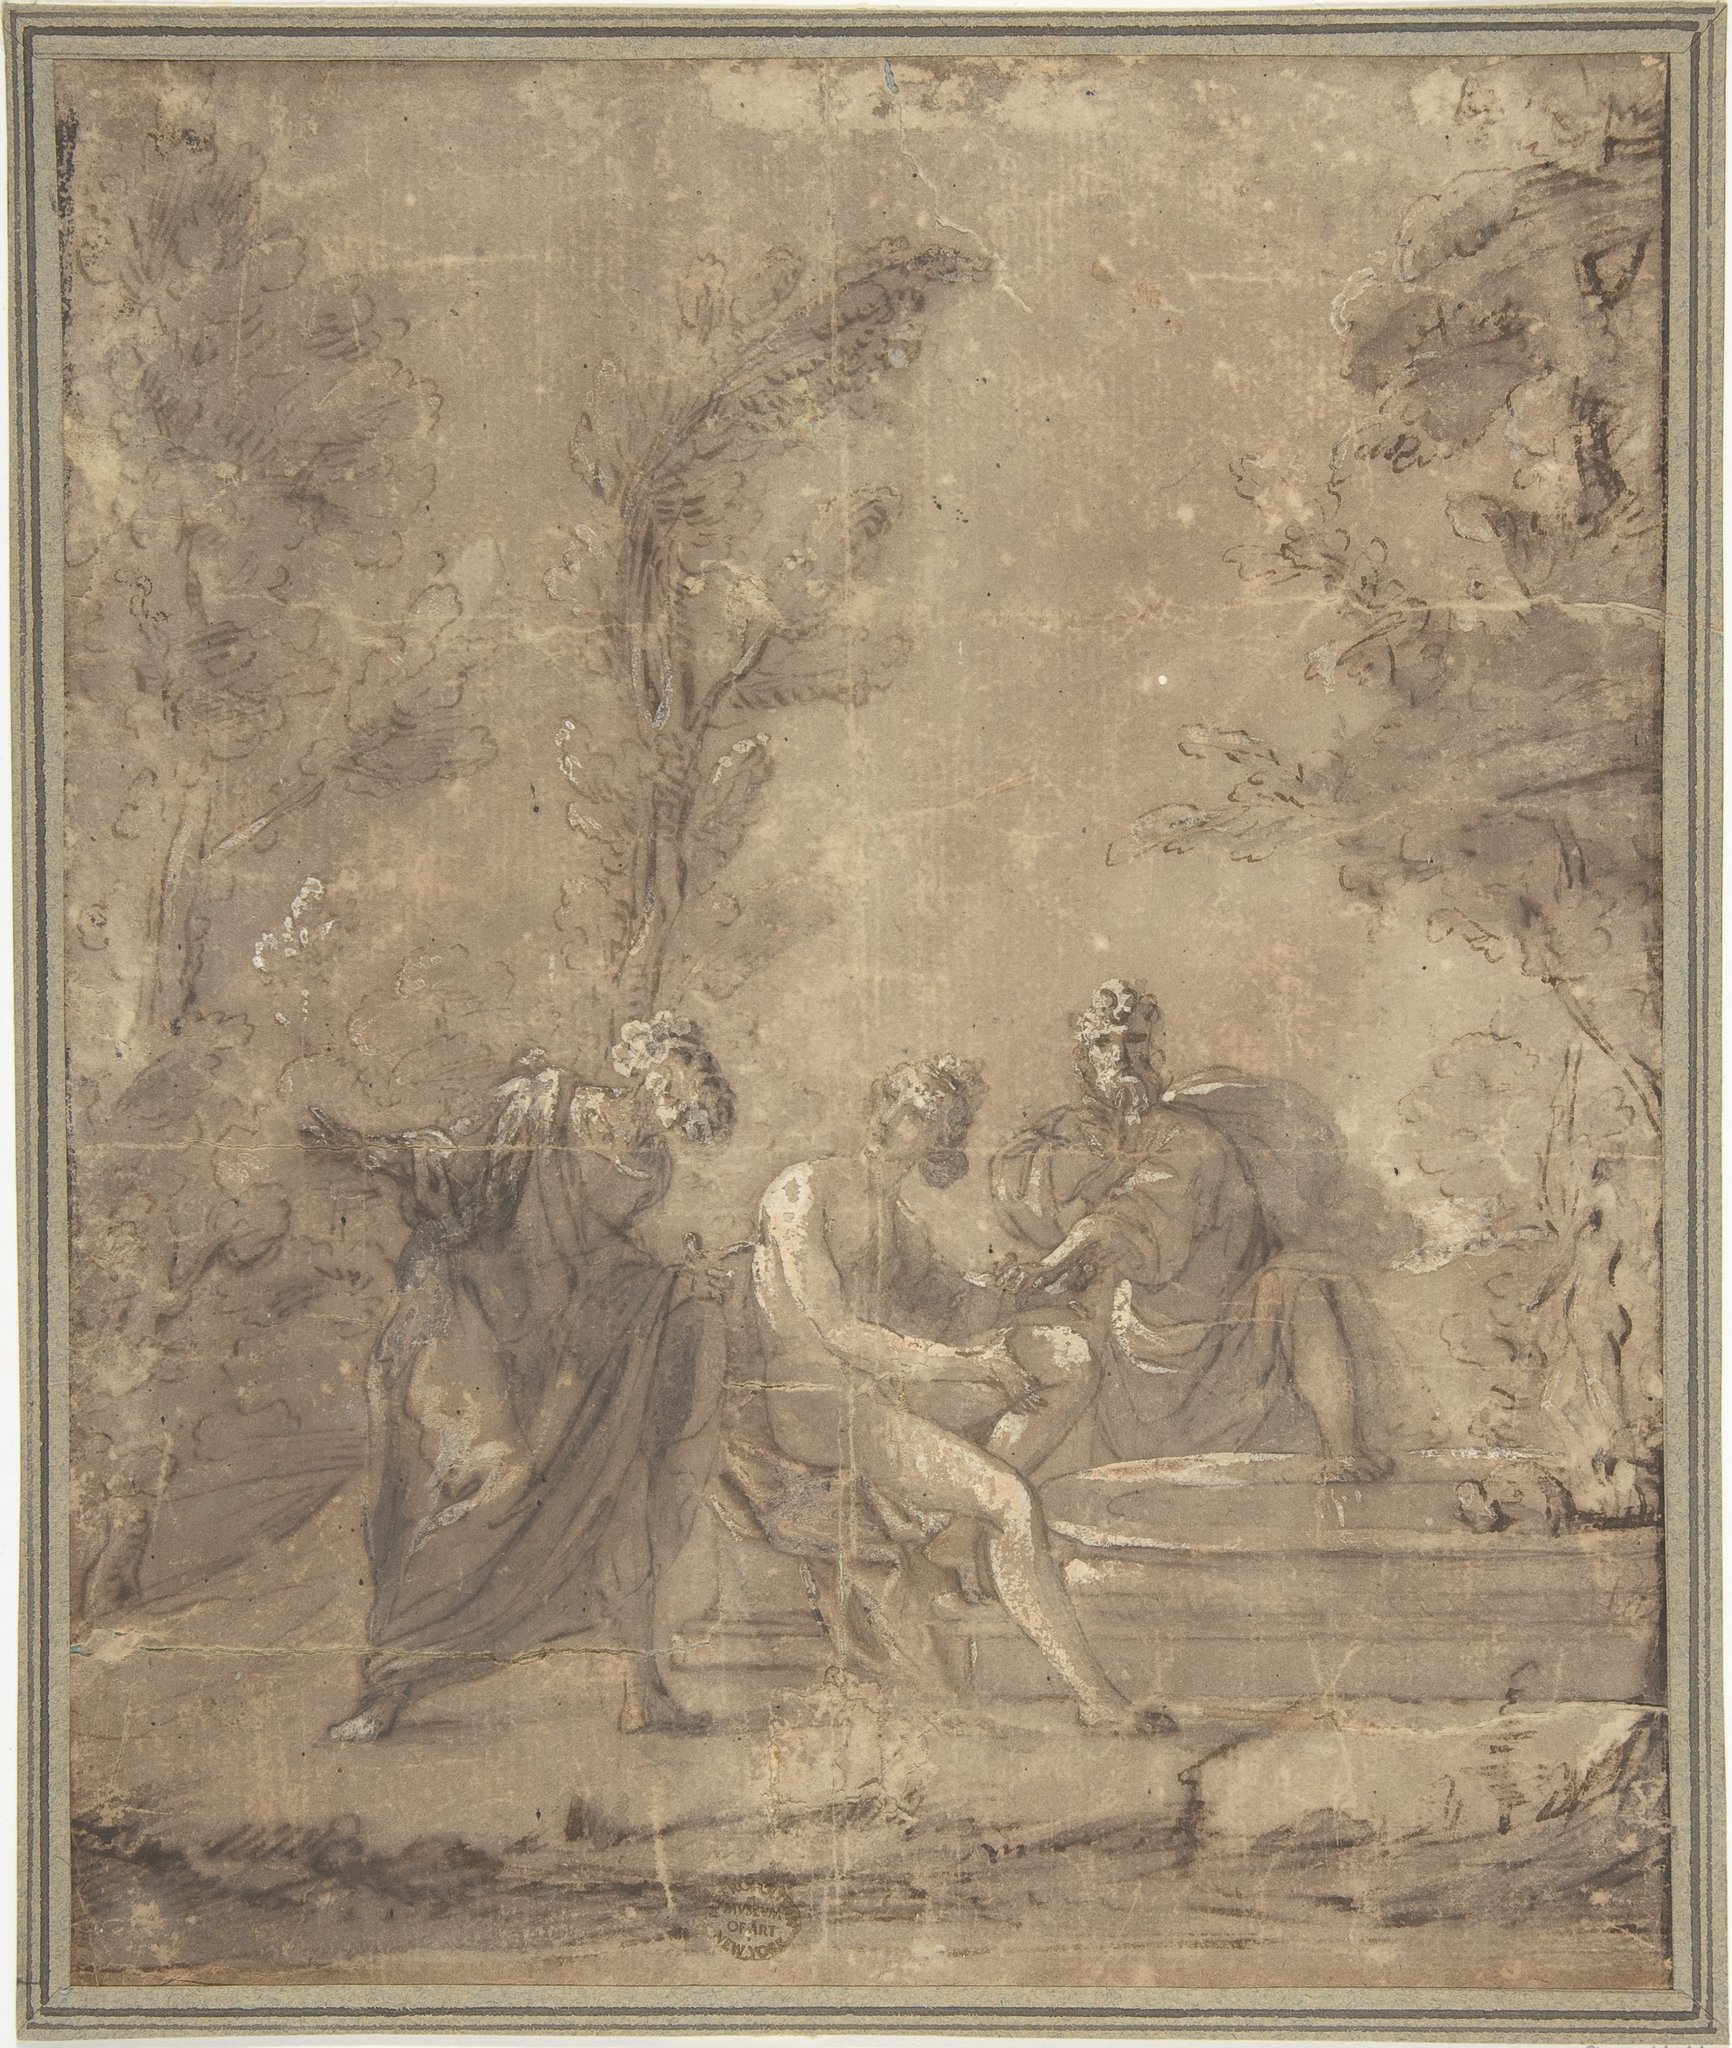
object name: drawing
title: Susannah and the Elders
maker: anonymous, german, 19th century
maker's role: artist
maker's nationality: german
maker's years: 1800-1899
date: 1801-1900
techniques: pen, wash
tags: men,female nudes